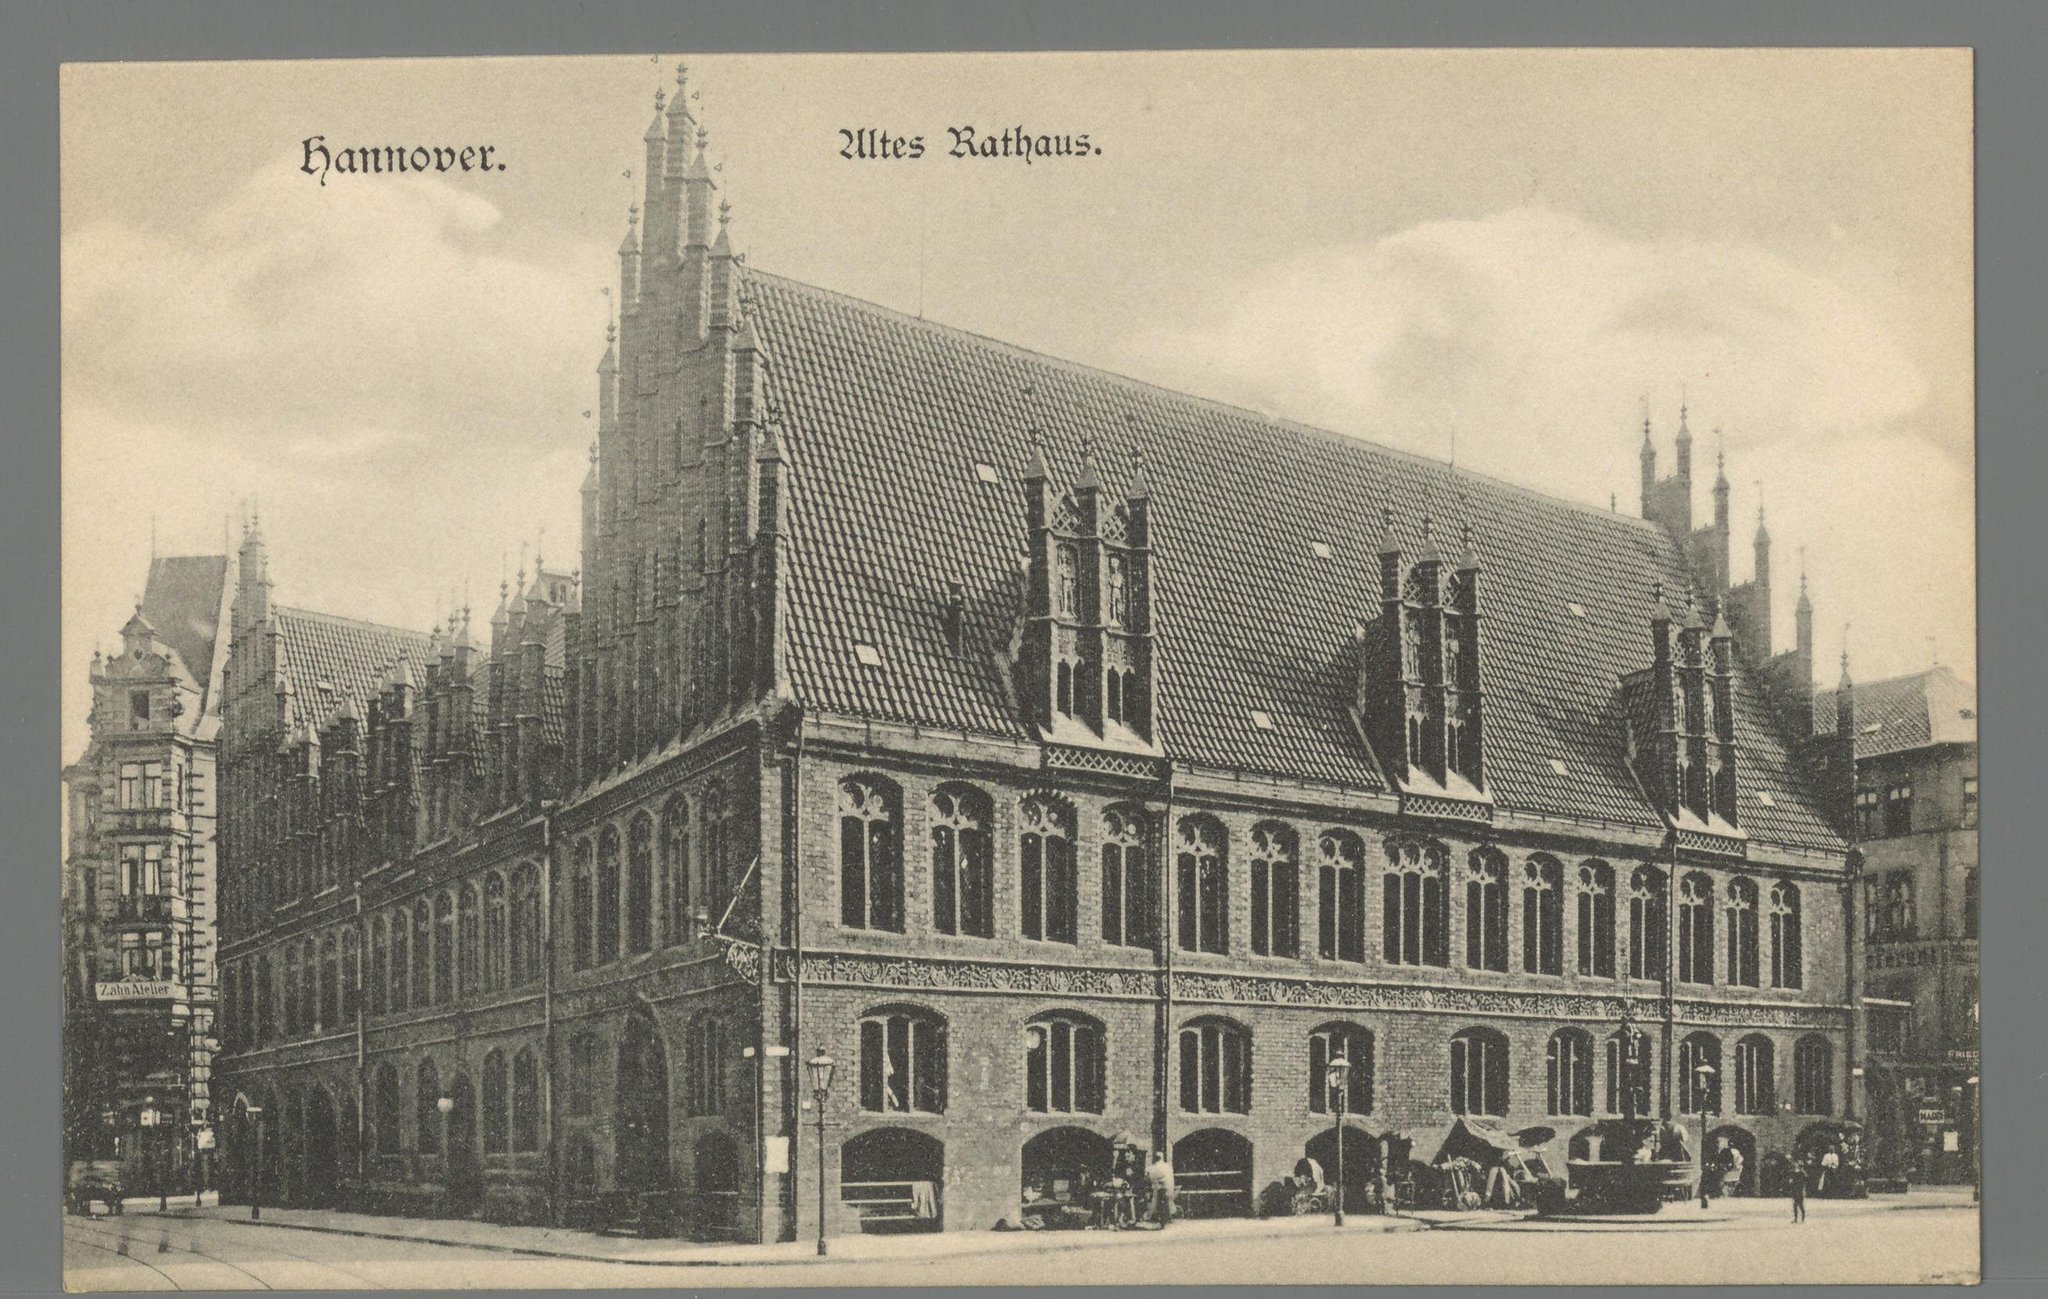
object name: ansichtkaart, prentbriefkaart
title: Hannover. Altes Rathaus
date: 1905-1906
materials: cardboard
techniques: photograph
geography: hannover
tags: townhall